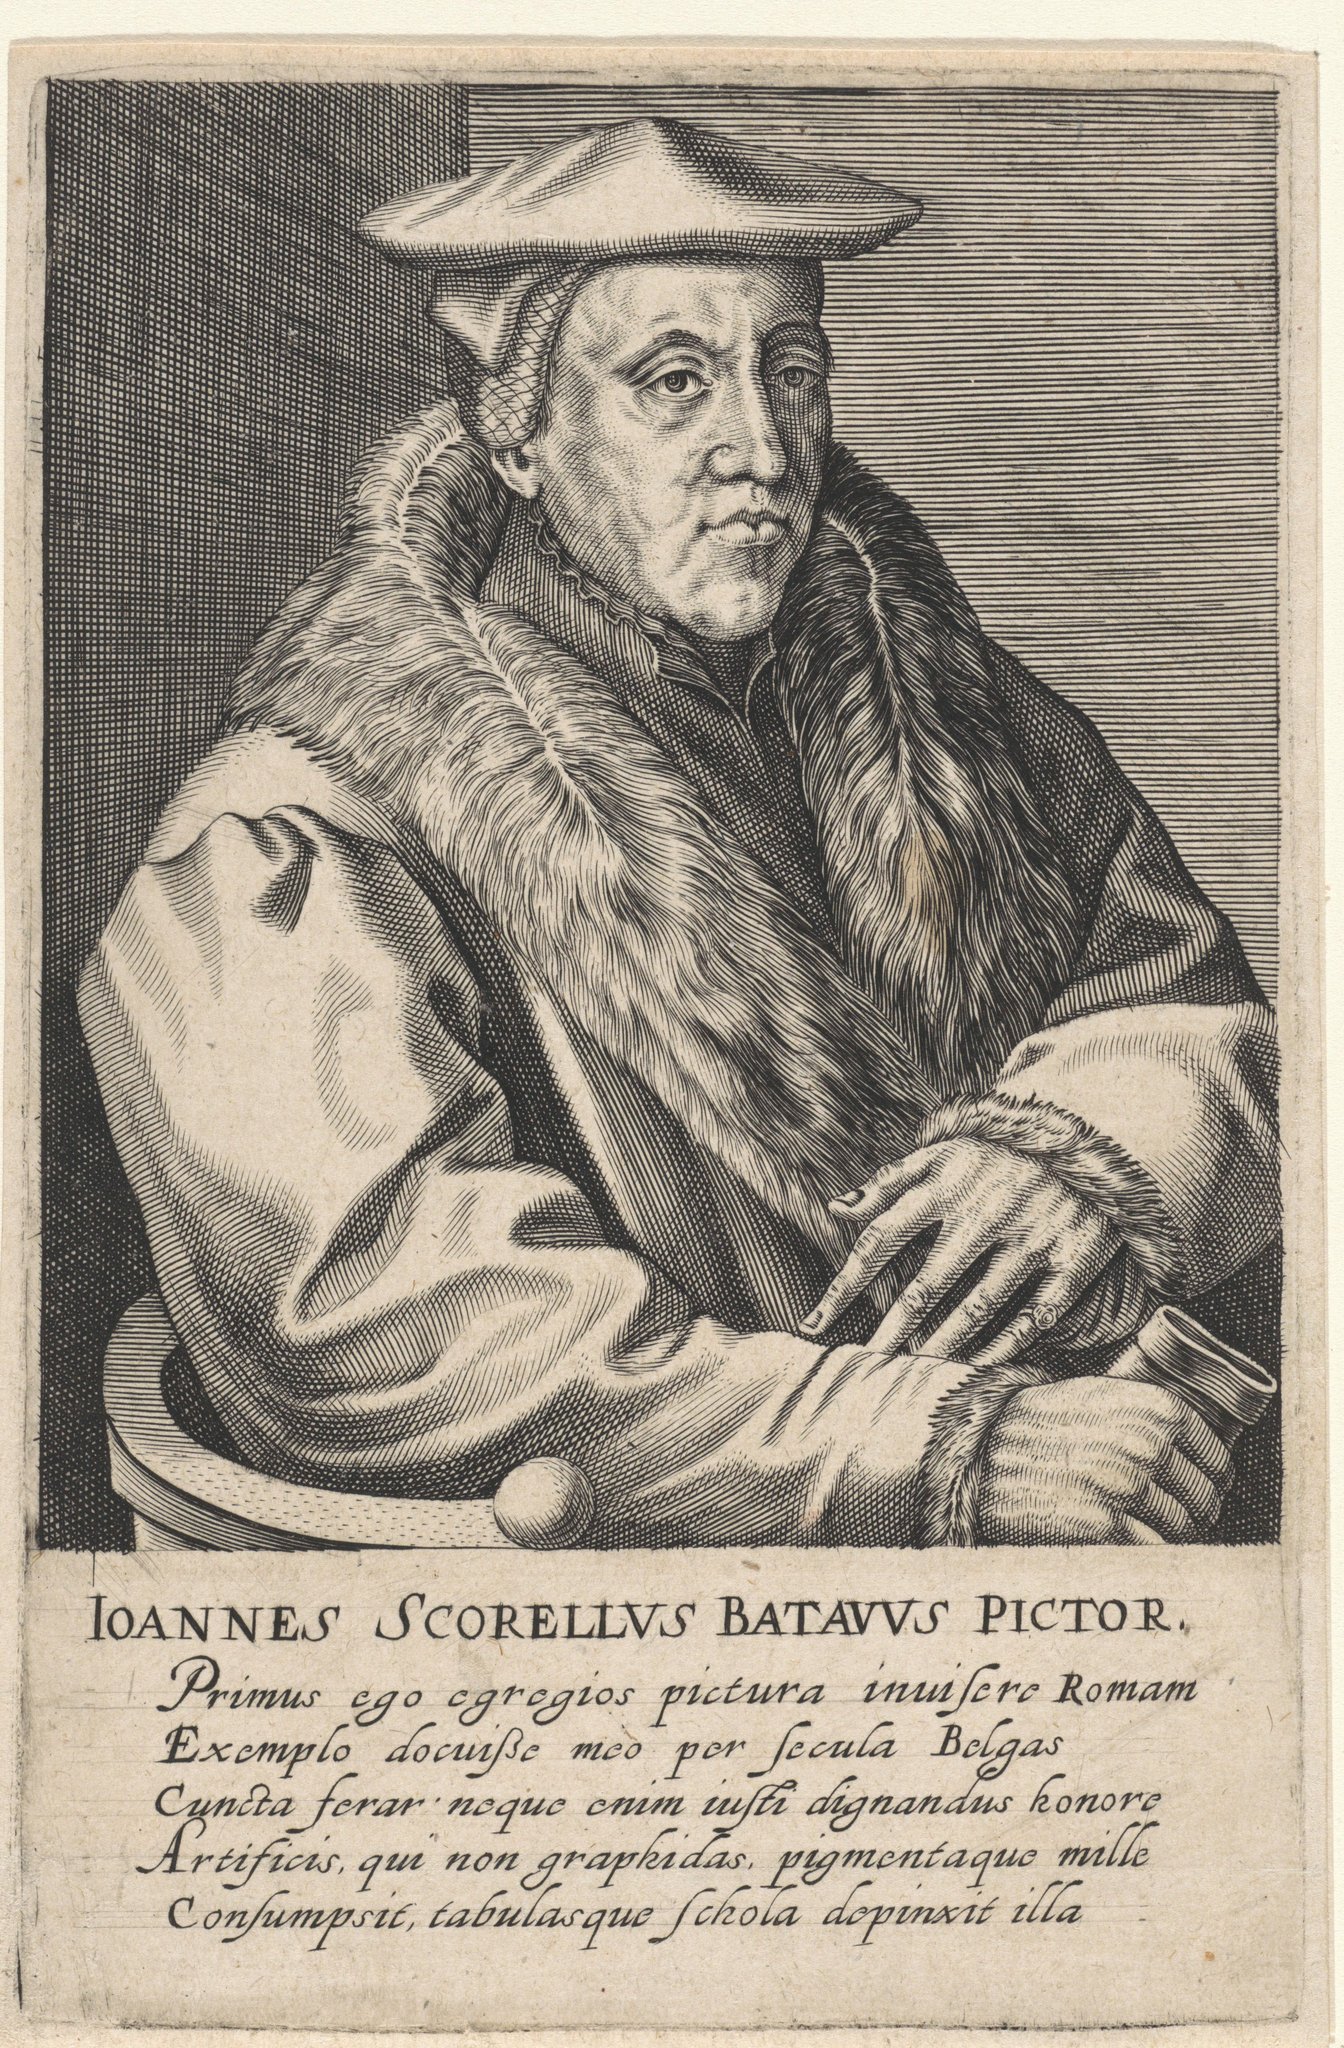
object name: print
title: Portret van Jan van Scorel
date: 1610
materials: paper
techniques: engraving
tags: utrecht, painter, print maker, draughtsman, jan van scorel, portrait, self-portrait of painter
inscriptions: collector's mark: Lugt 2228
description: In de marge een vijfregelig onderschrift in het Latijn.